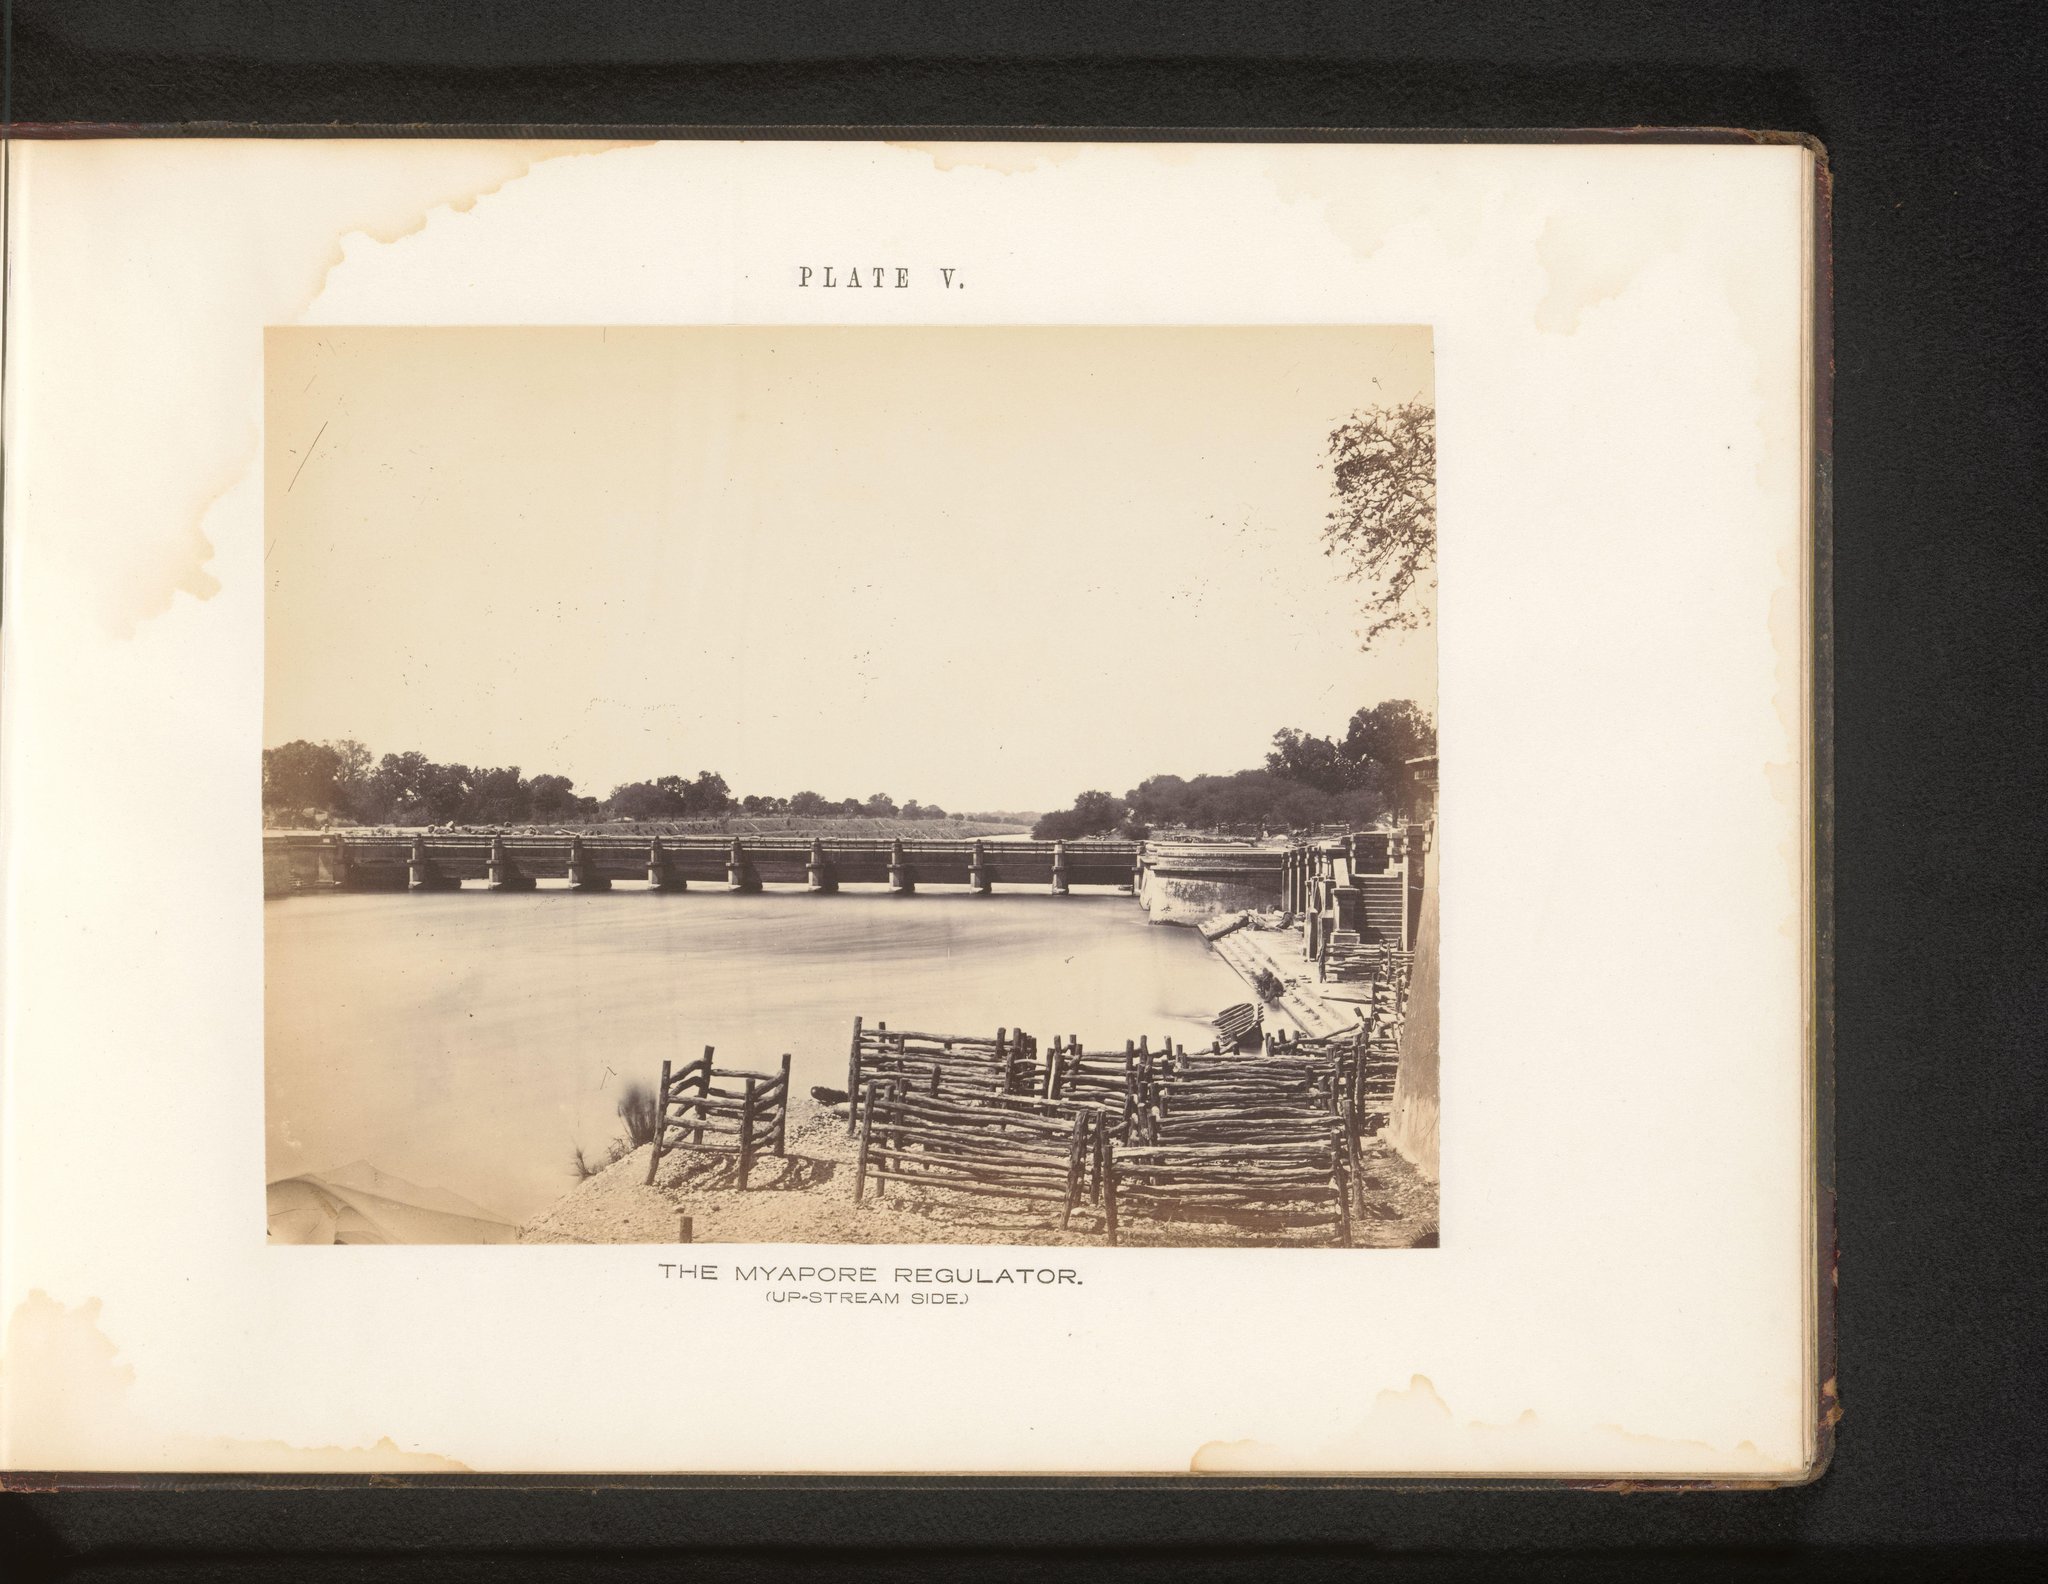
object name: page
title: The Myapore regulator ( up-stream side)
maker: thomas george glover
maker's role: fotograaf, luitenant-kolonel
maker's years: 1825-1881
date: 1862-1867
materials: photographic support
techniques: albumen print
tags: river, dam (in canal)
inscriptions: inscription: ‘Plate V’